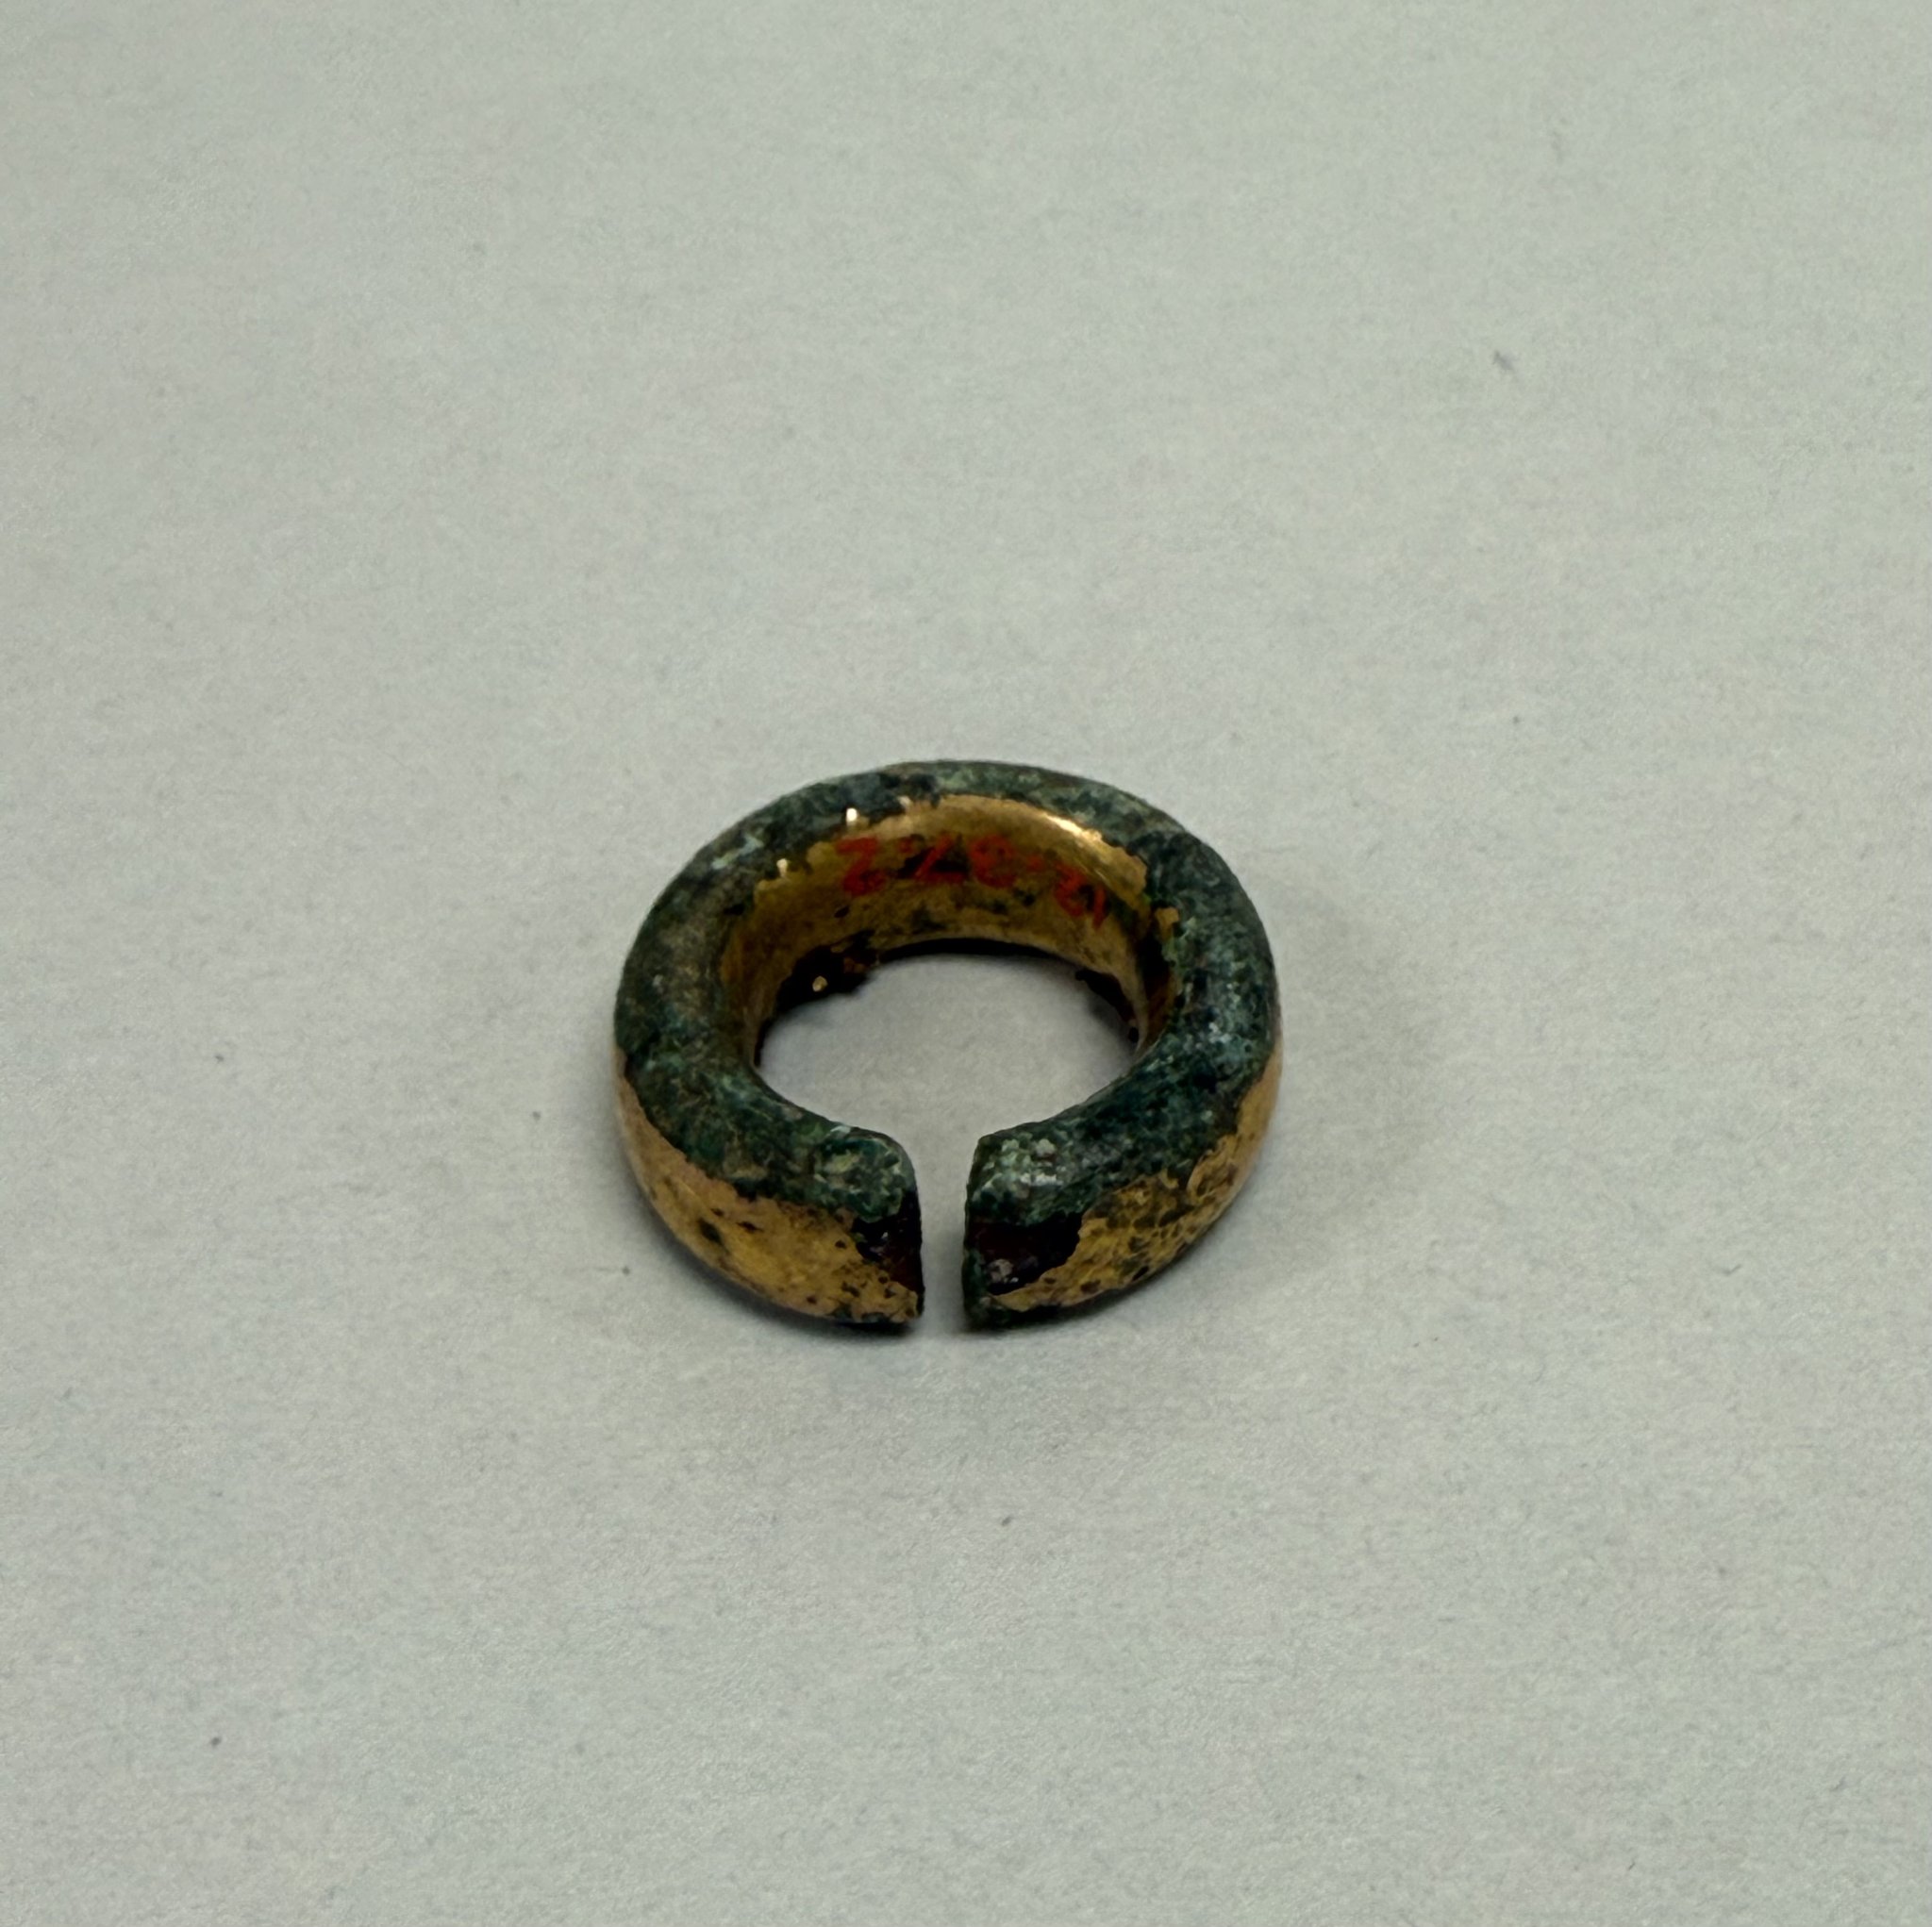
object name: earring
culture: japanese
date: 601-700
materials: copper gilt